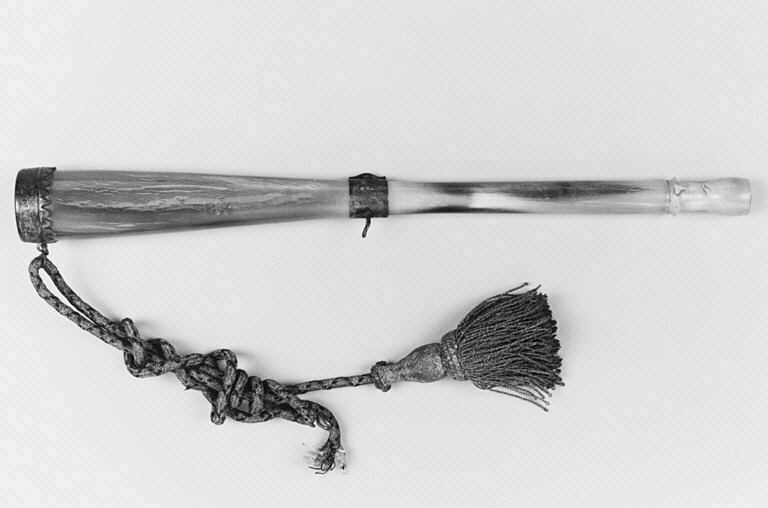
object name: rufhorn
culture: european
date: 1601-1700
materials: horn